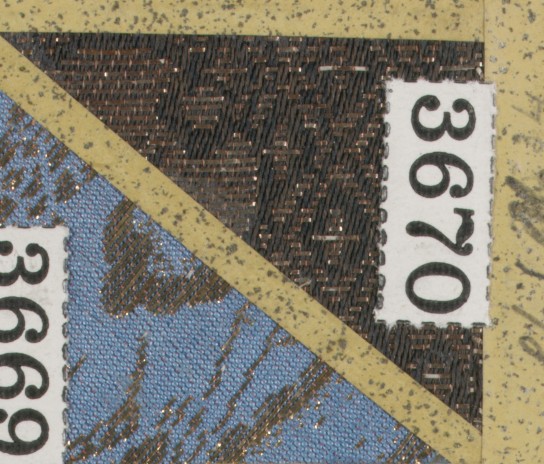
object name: sample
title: Textile Sample from Sample Book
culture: japanese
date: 1801-1900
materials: silk